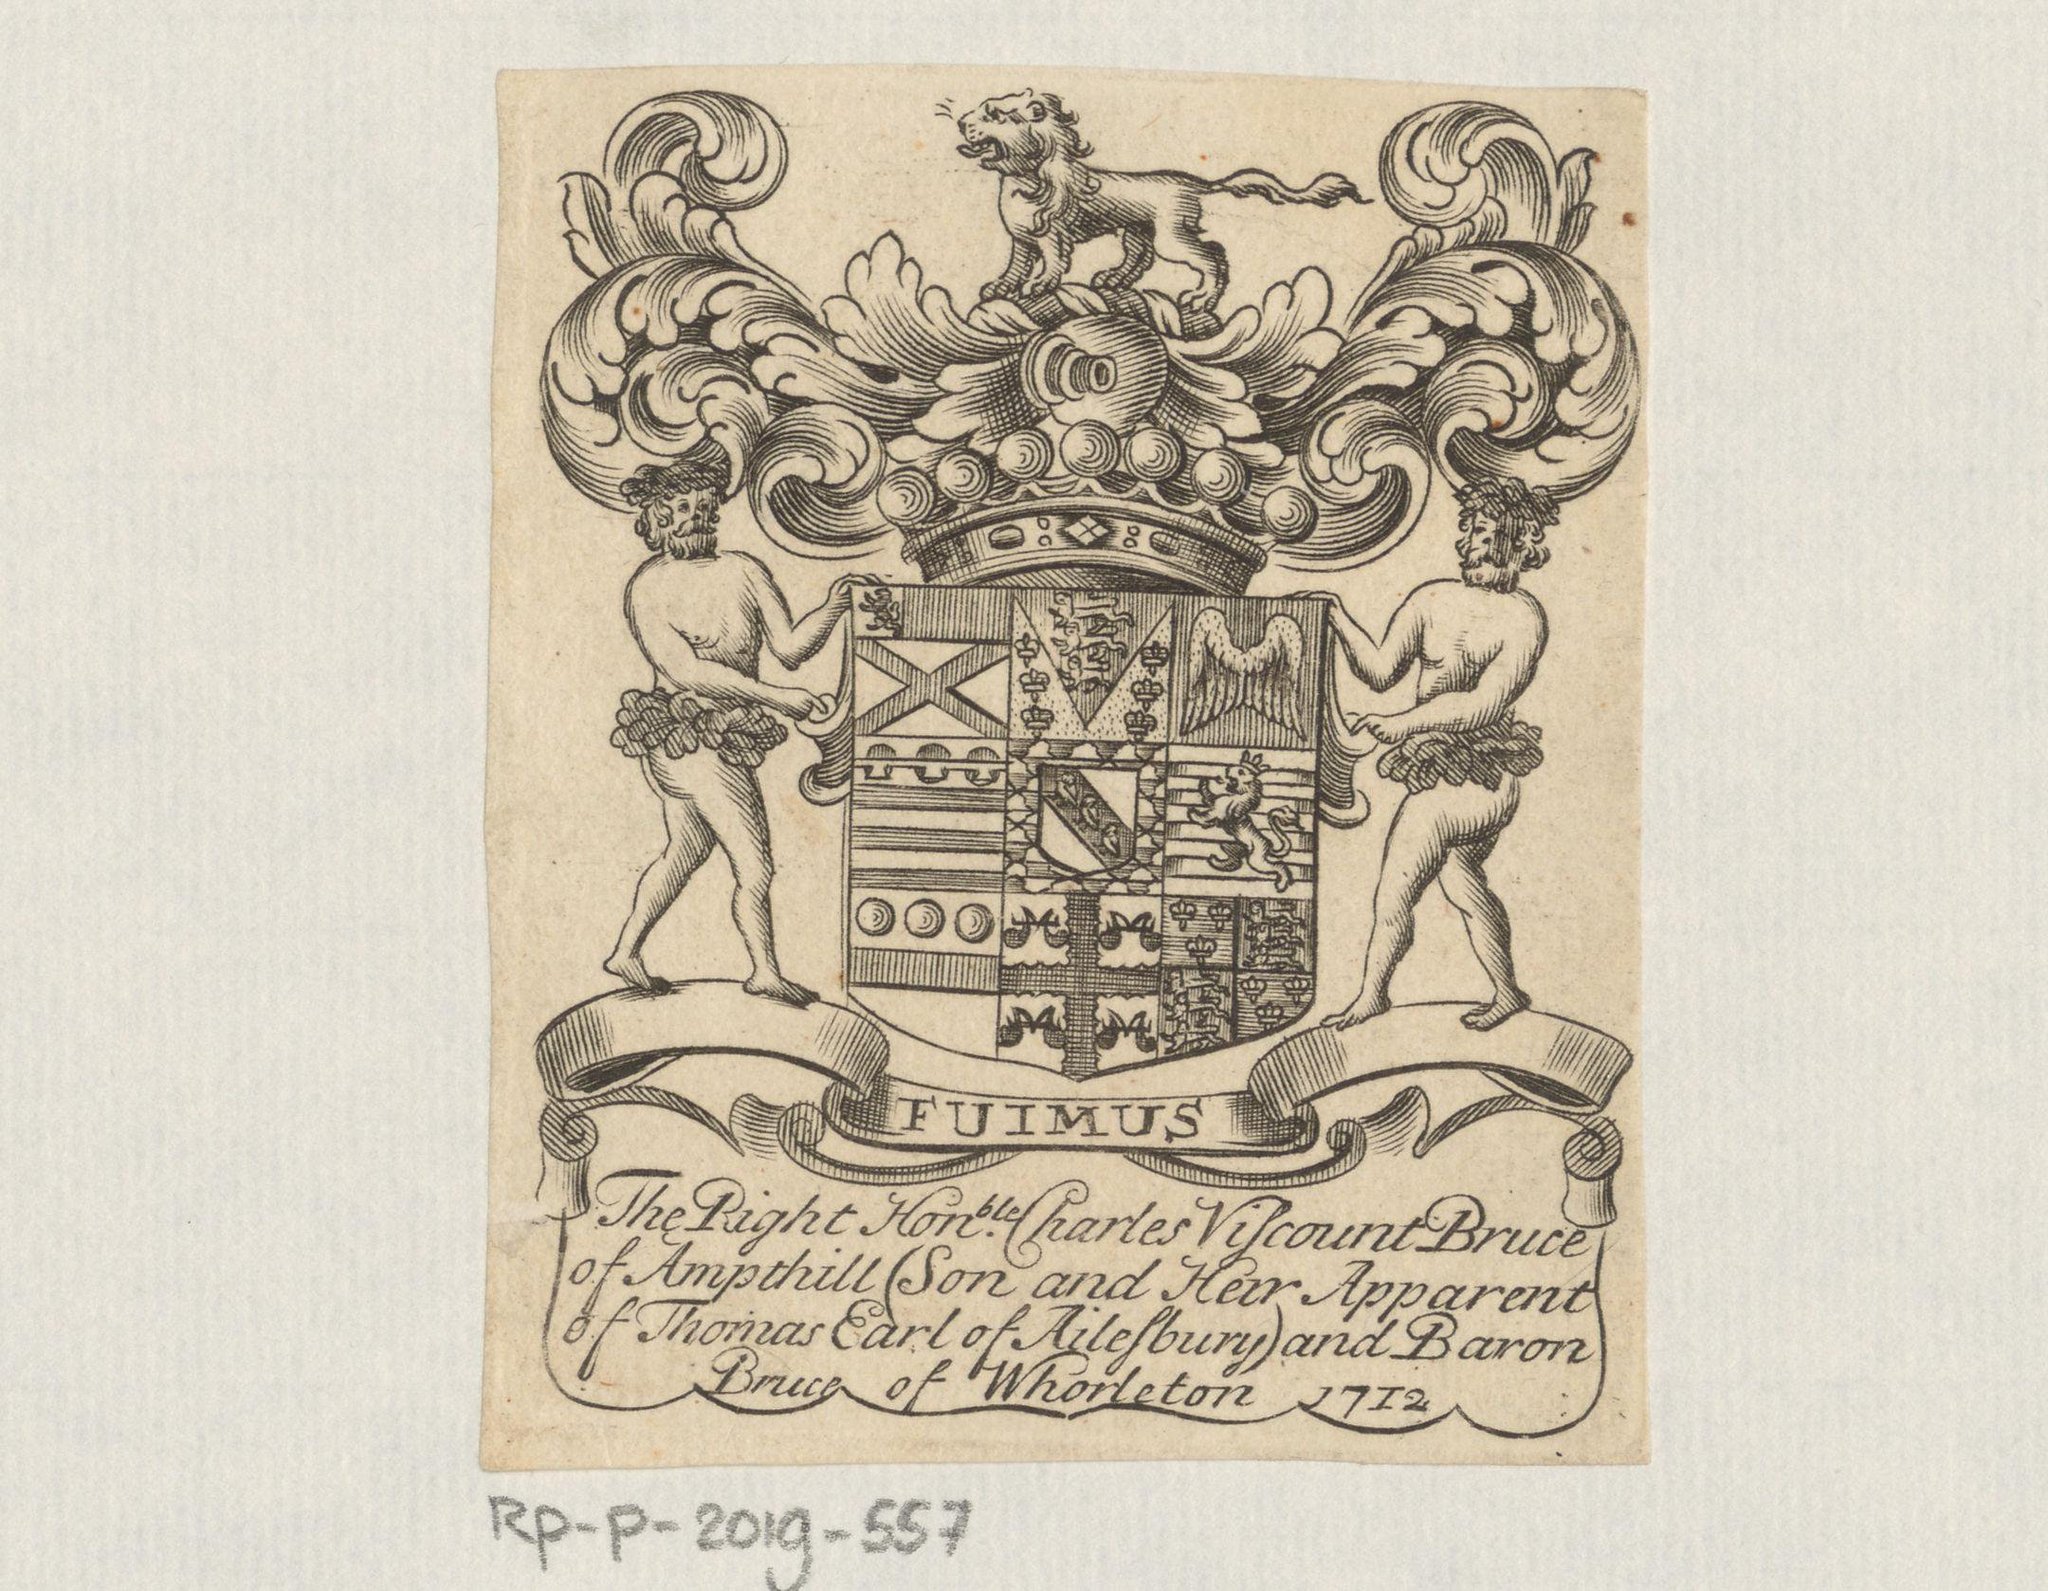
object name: bookplate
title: Ex libris van Charles Viscount Bruce of Ampthill (Son and Heir Apparent of Thomas Earl of Ailesbury) and Baron Bruce of Whorleton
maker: Anonymous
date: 1712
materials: paper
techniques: engraving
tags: earl, politician, wild man, wodewose, woodehouse, armorial bearing, heraldry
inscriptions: date